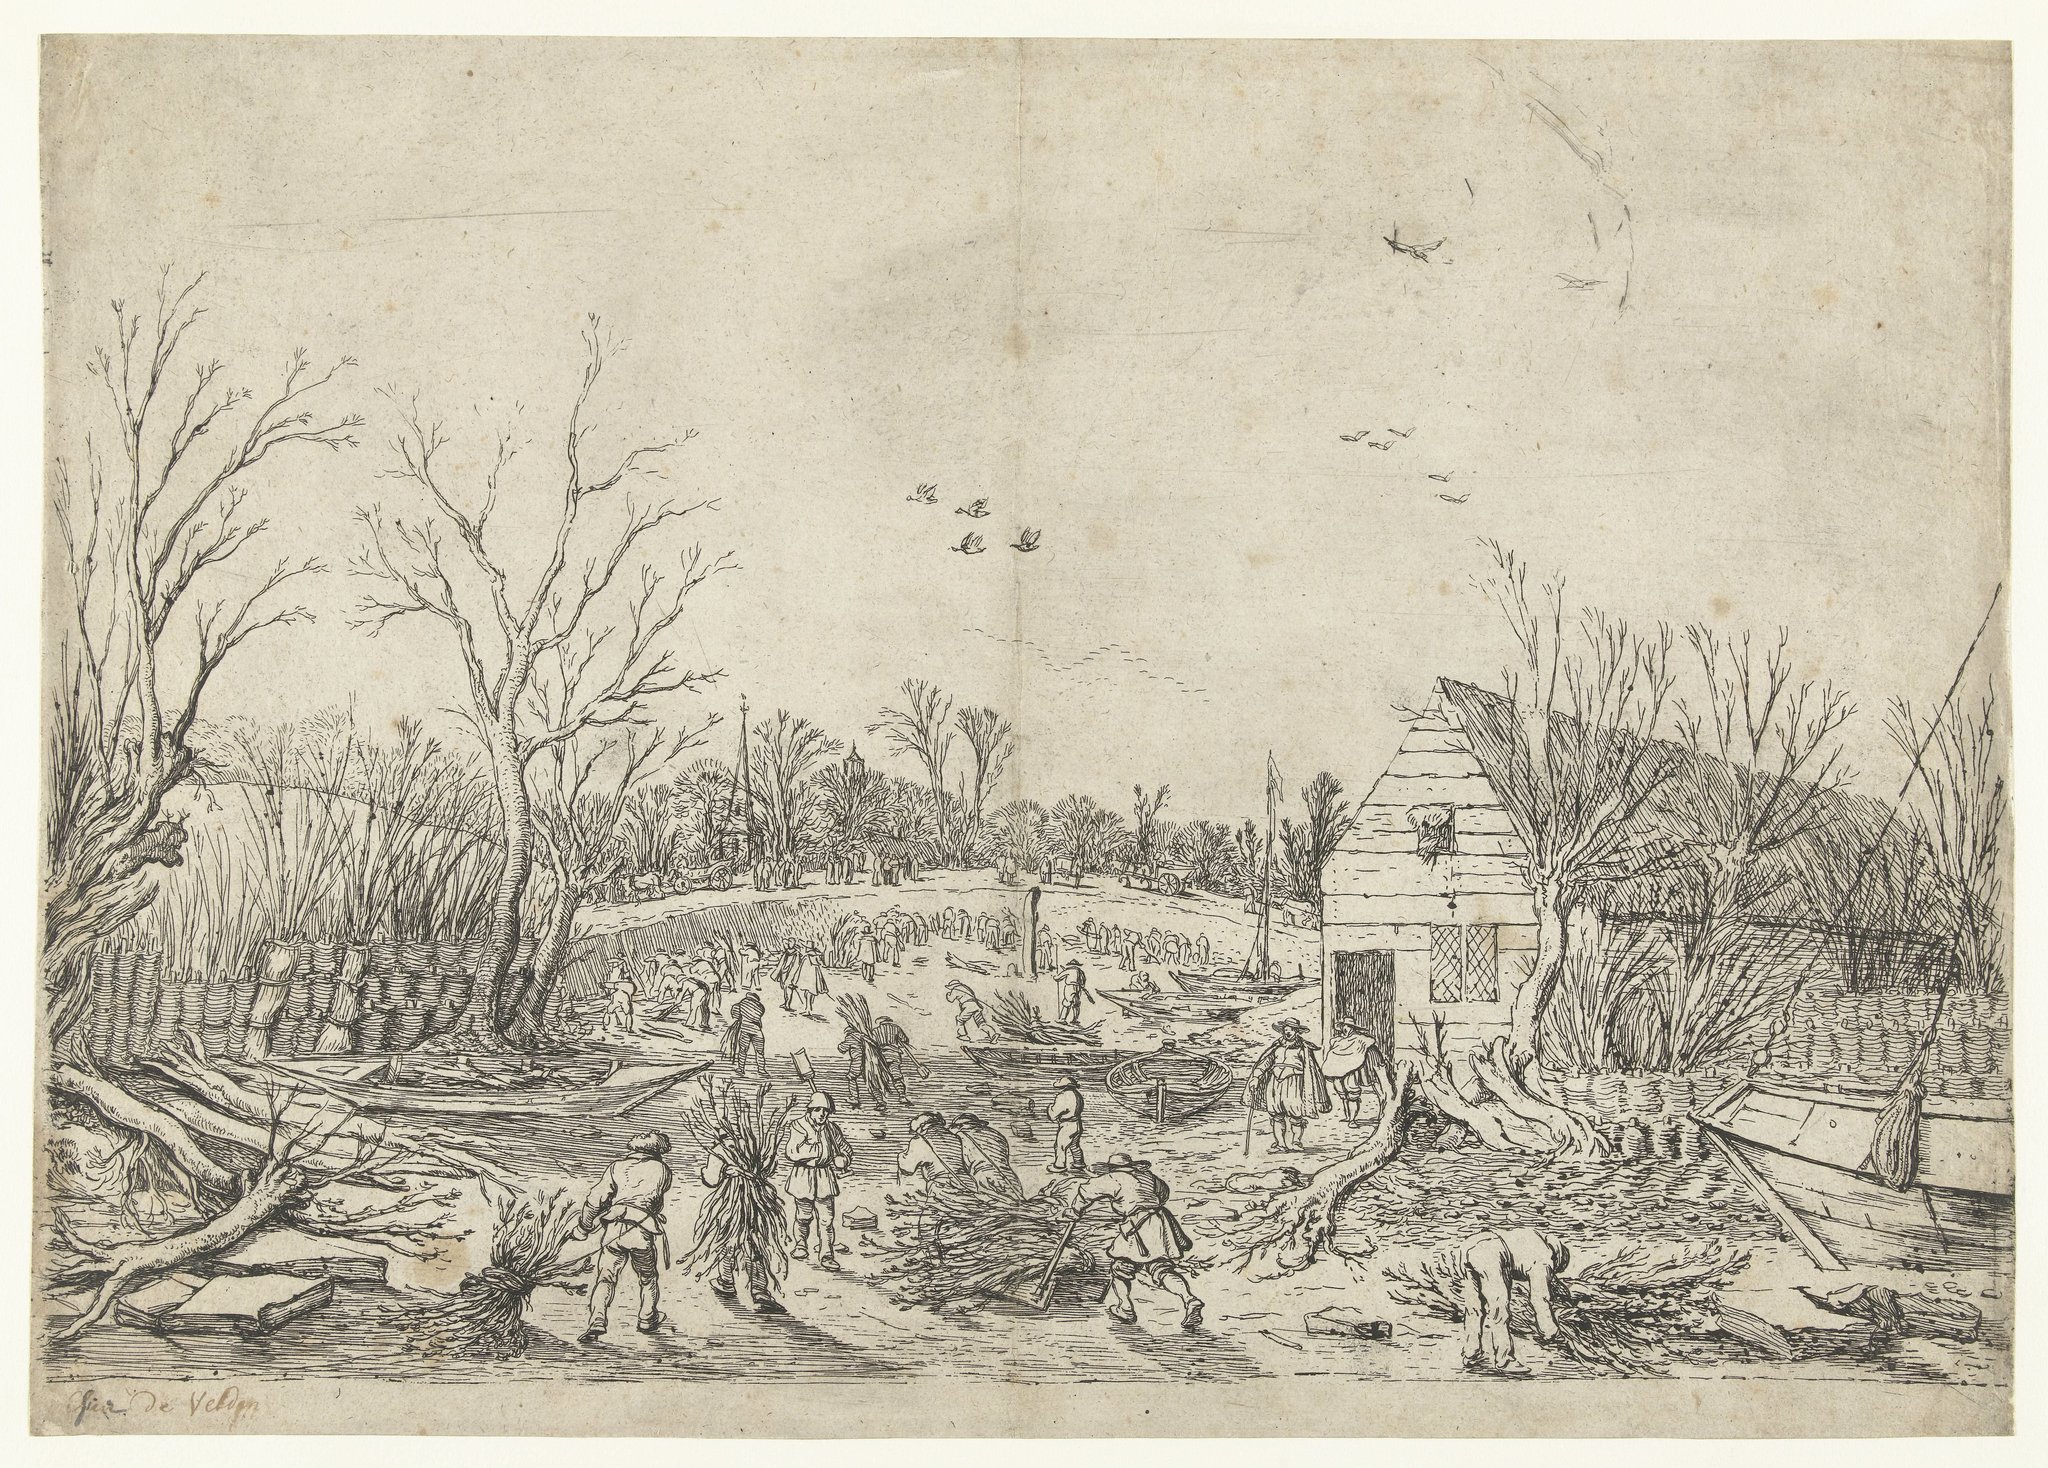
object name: print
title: Herstelwerkzaamheden aan de doorgebroken Lekdijk bij 't Waal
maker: esaias van de velde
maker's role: draughtsman, painter, print maker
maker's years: 1587-1630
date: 1624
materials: paper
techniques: etching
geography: netherlands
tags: dike-break, dry river, river bed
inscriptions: collector's mark: Lugt 2228, signature: ‘Esias de Velden’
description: De doorgebroken noordelijke Lekdijk in 1624. Mannen met takkenbossen op hun rug lopend door de droge rivierbedding van de Lek. Boten zijn drooggelegd. Met takken wordt de Lekdijk hersteld. In de verte de kerktoren van 't Waal en de Domtoren van Utrecht.